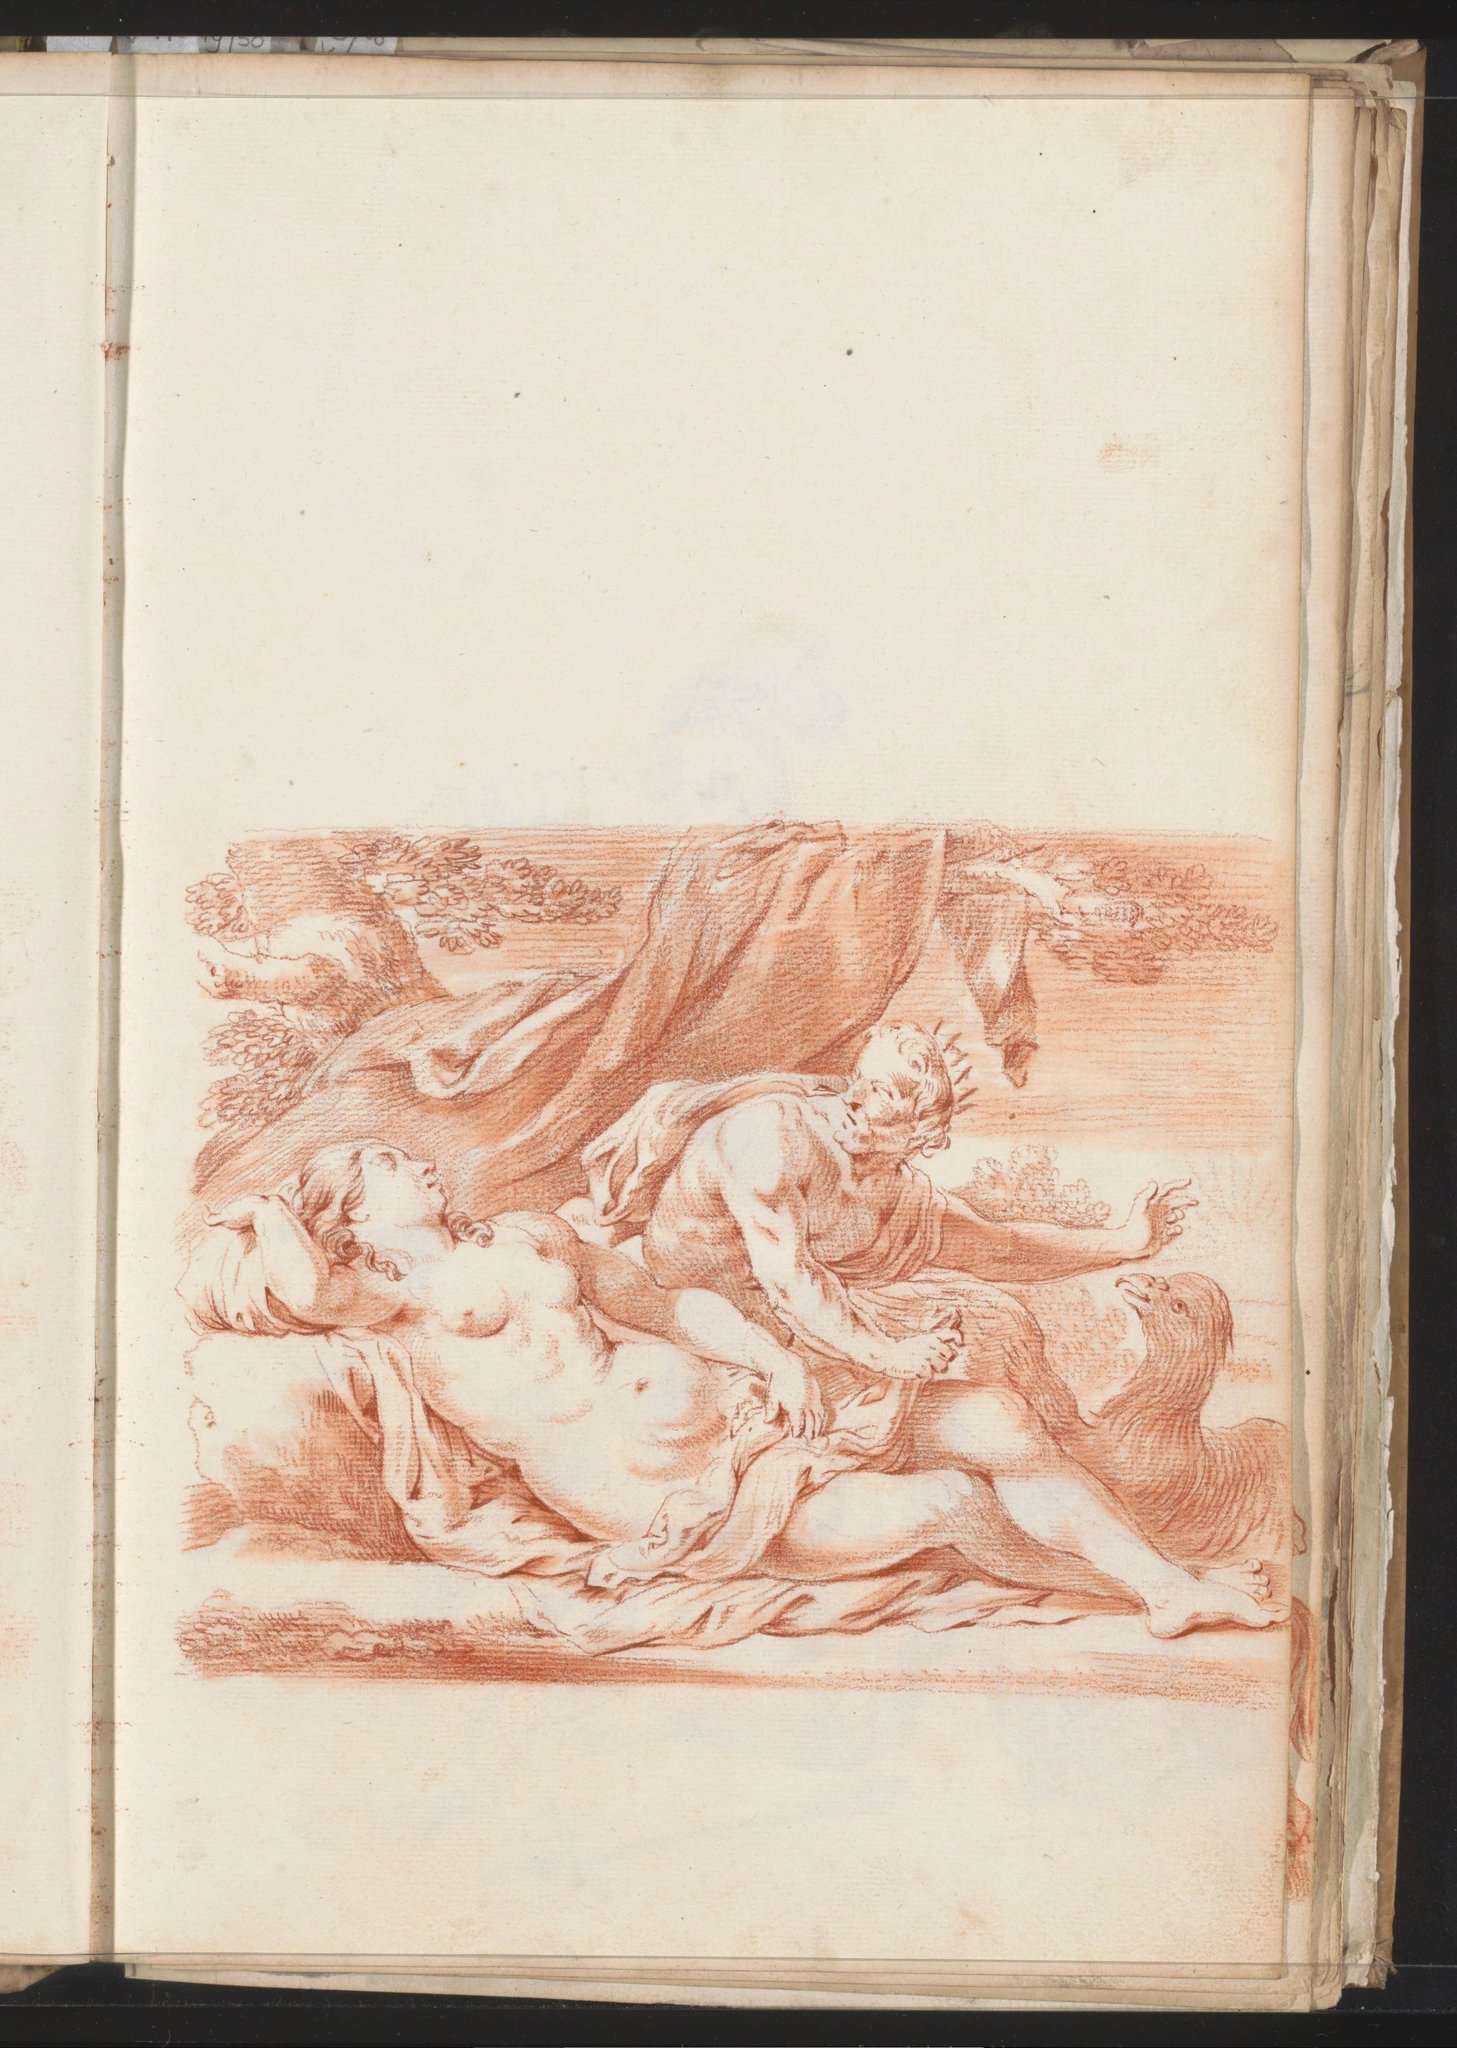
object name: sketchbook leaf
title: Jupiter met een geliefde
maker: jacob toorenvliet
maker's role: draughtsman, painter, print maker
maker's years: 1640-1719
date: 1701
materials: chalk, paper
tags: love-affairs of jupiter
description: De gekroonde Jupiter zit onder een boom bij een naakte geliefde. Naast hem zit een adelaar. Blad 41 recto uit een schetsboek met 63 bladen.